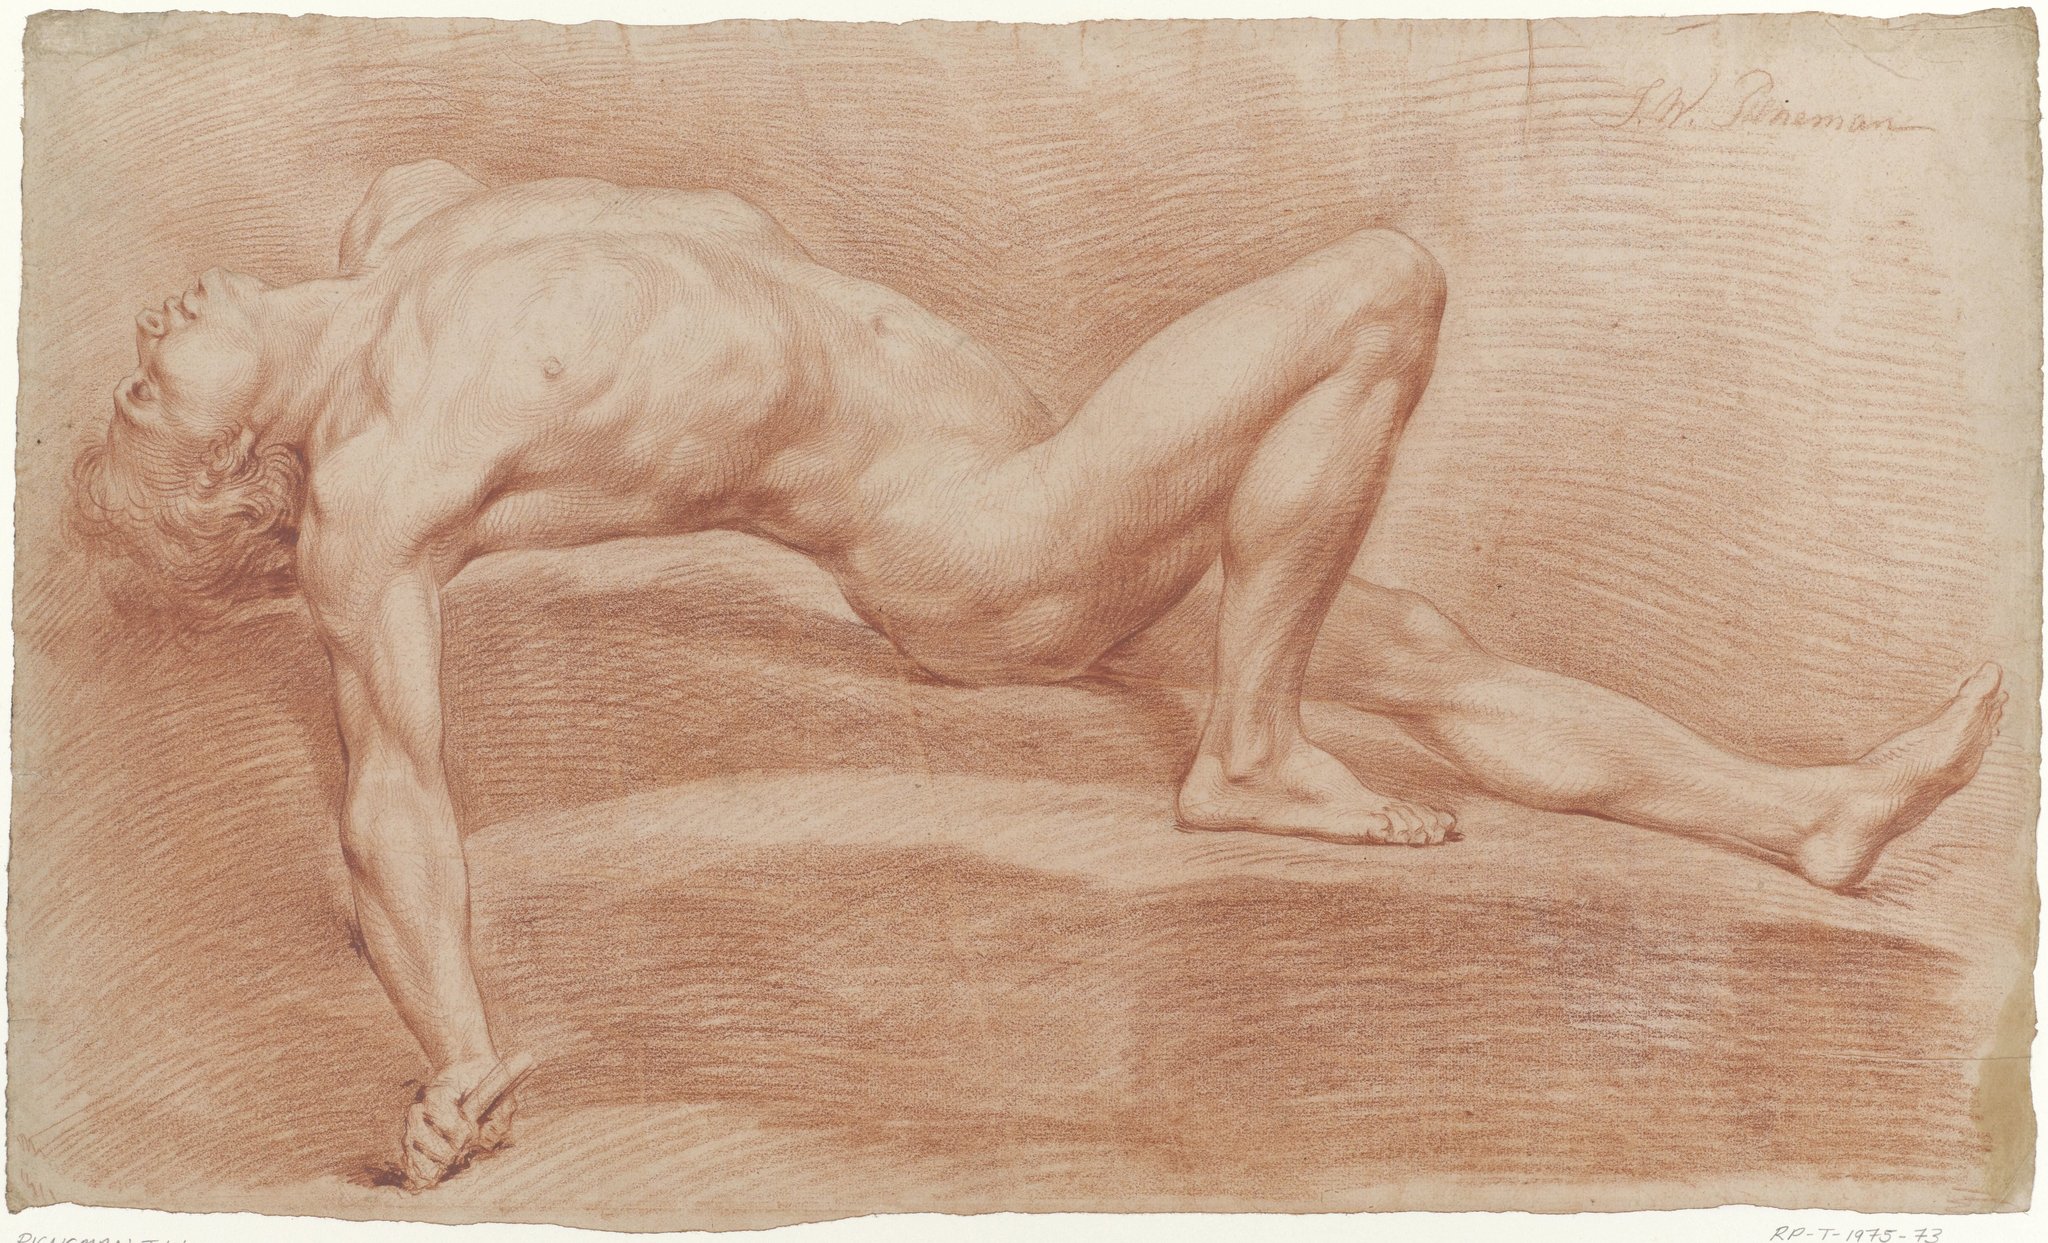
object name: drawing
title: Op de rug liggend mannelijk naakt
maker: jan willem pieneman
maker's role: draughtsman, painter, print maker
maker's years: 1779-1853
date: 1801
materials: chalk, paper